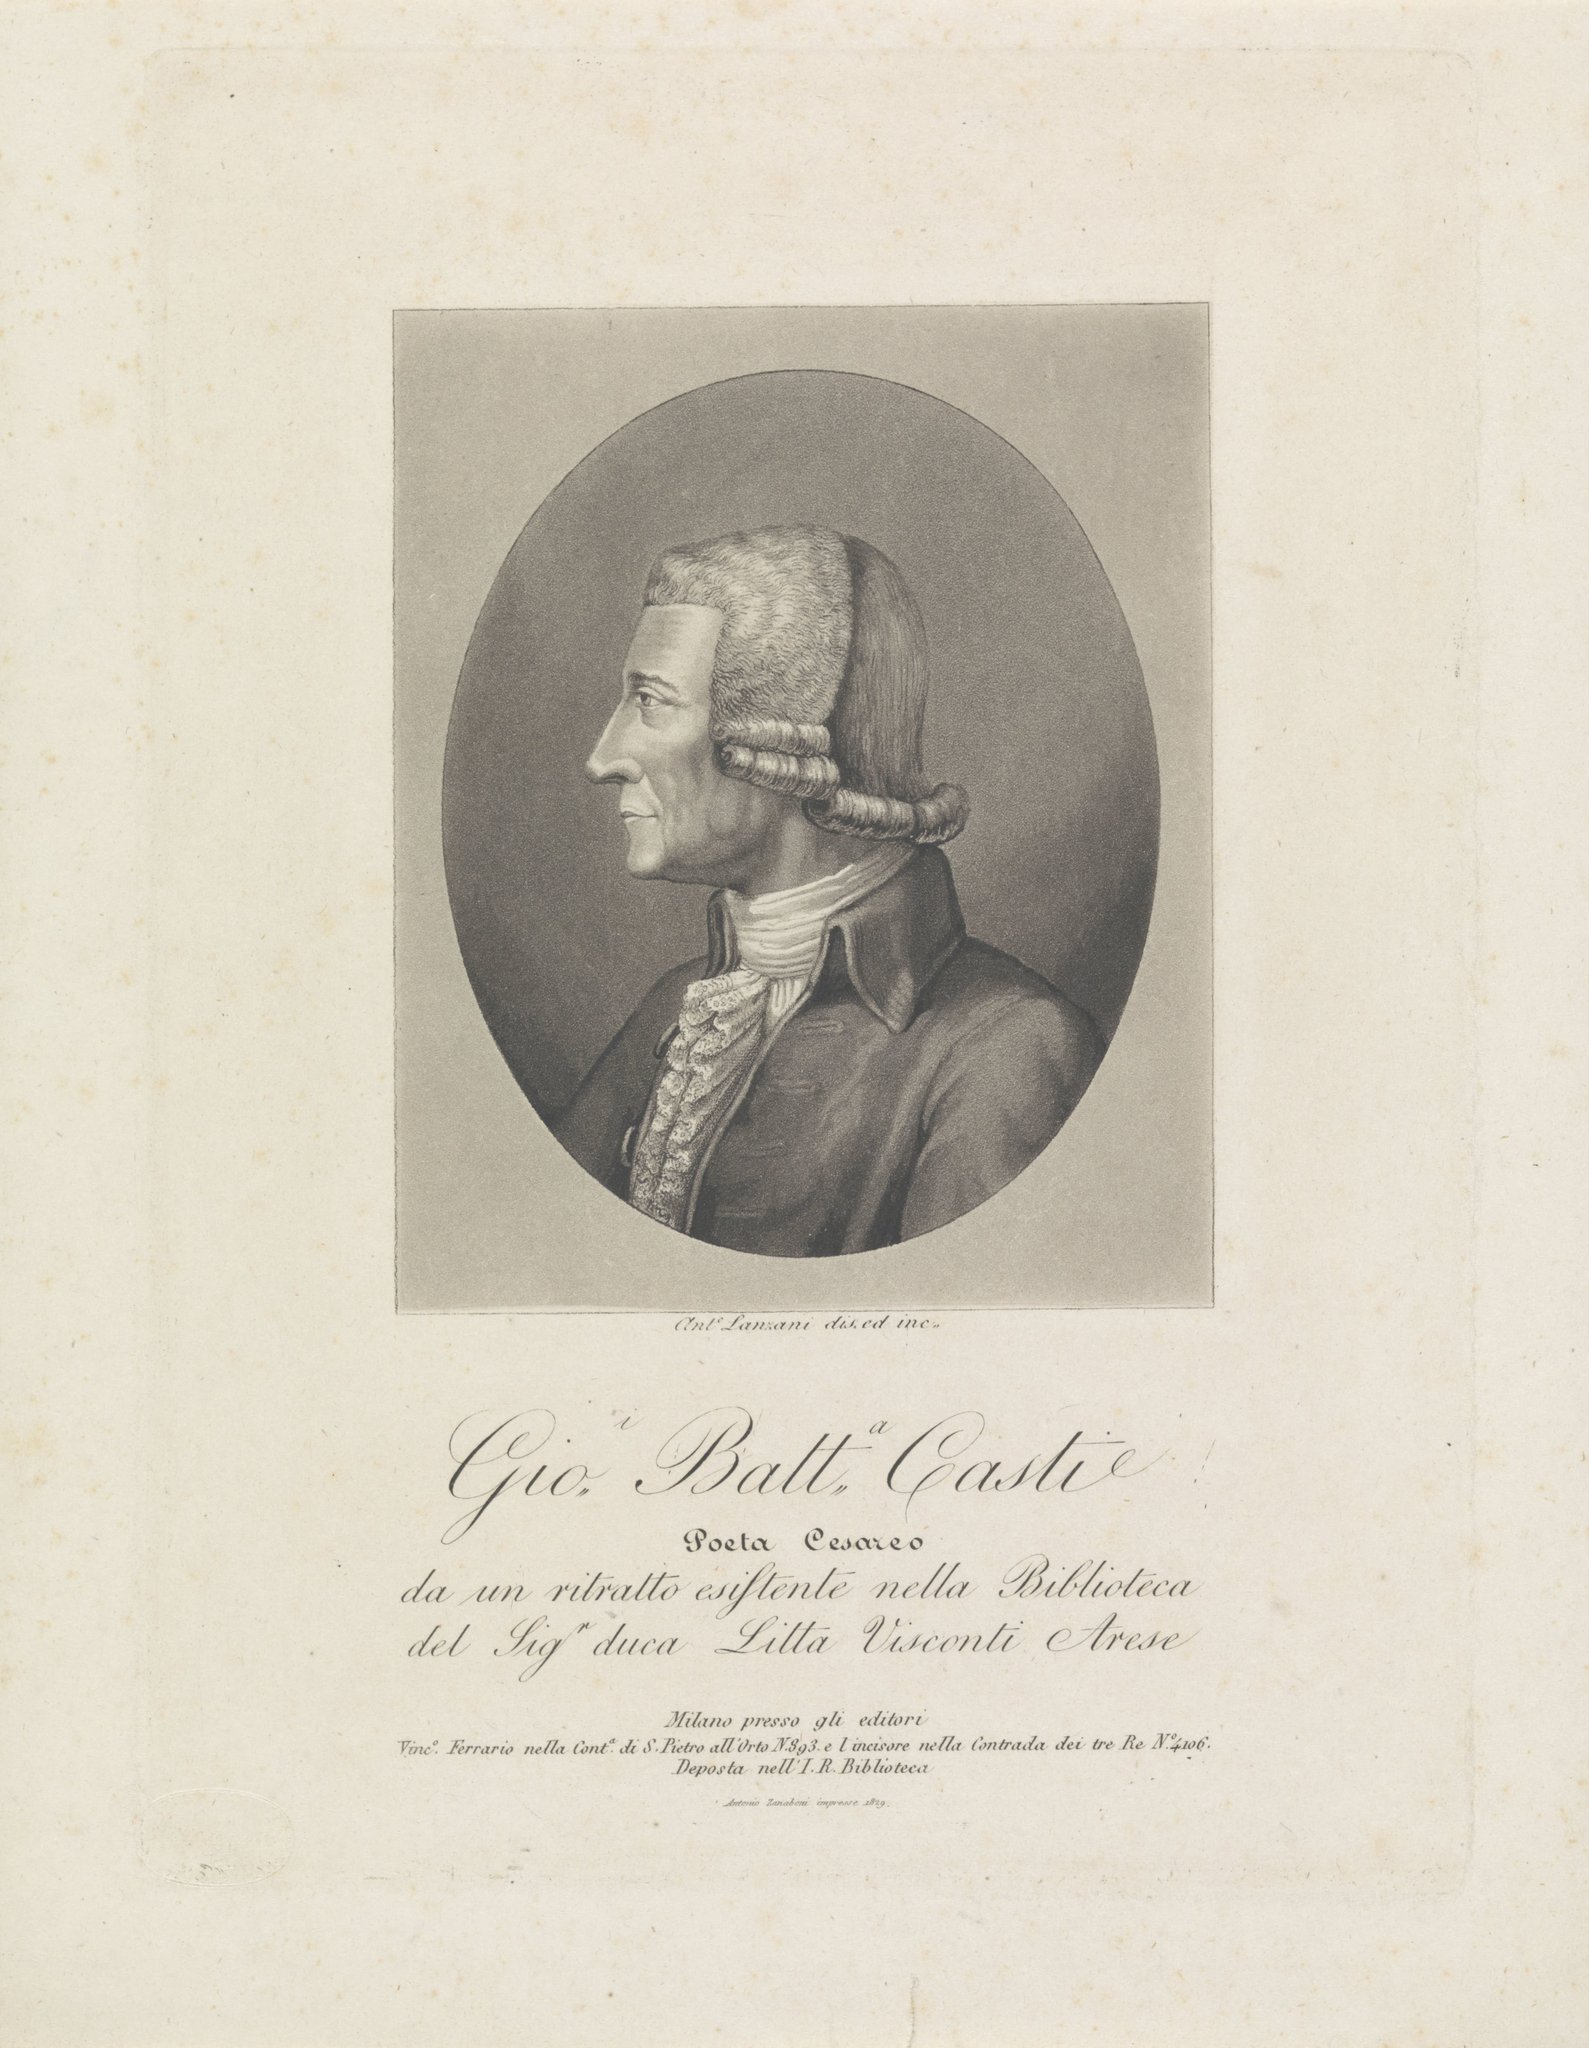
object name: print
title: Portret van dichter Giovanni Battista Casti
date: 1829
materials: paper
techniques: aquatint, etching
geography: italy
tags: paris, historical persons, portrait of a writer, writer, poet, author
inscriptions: collector's mark: Lugt 2228, collector's mark: ‘A. Lanzani’